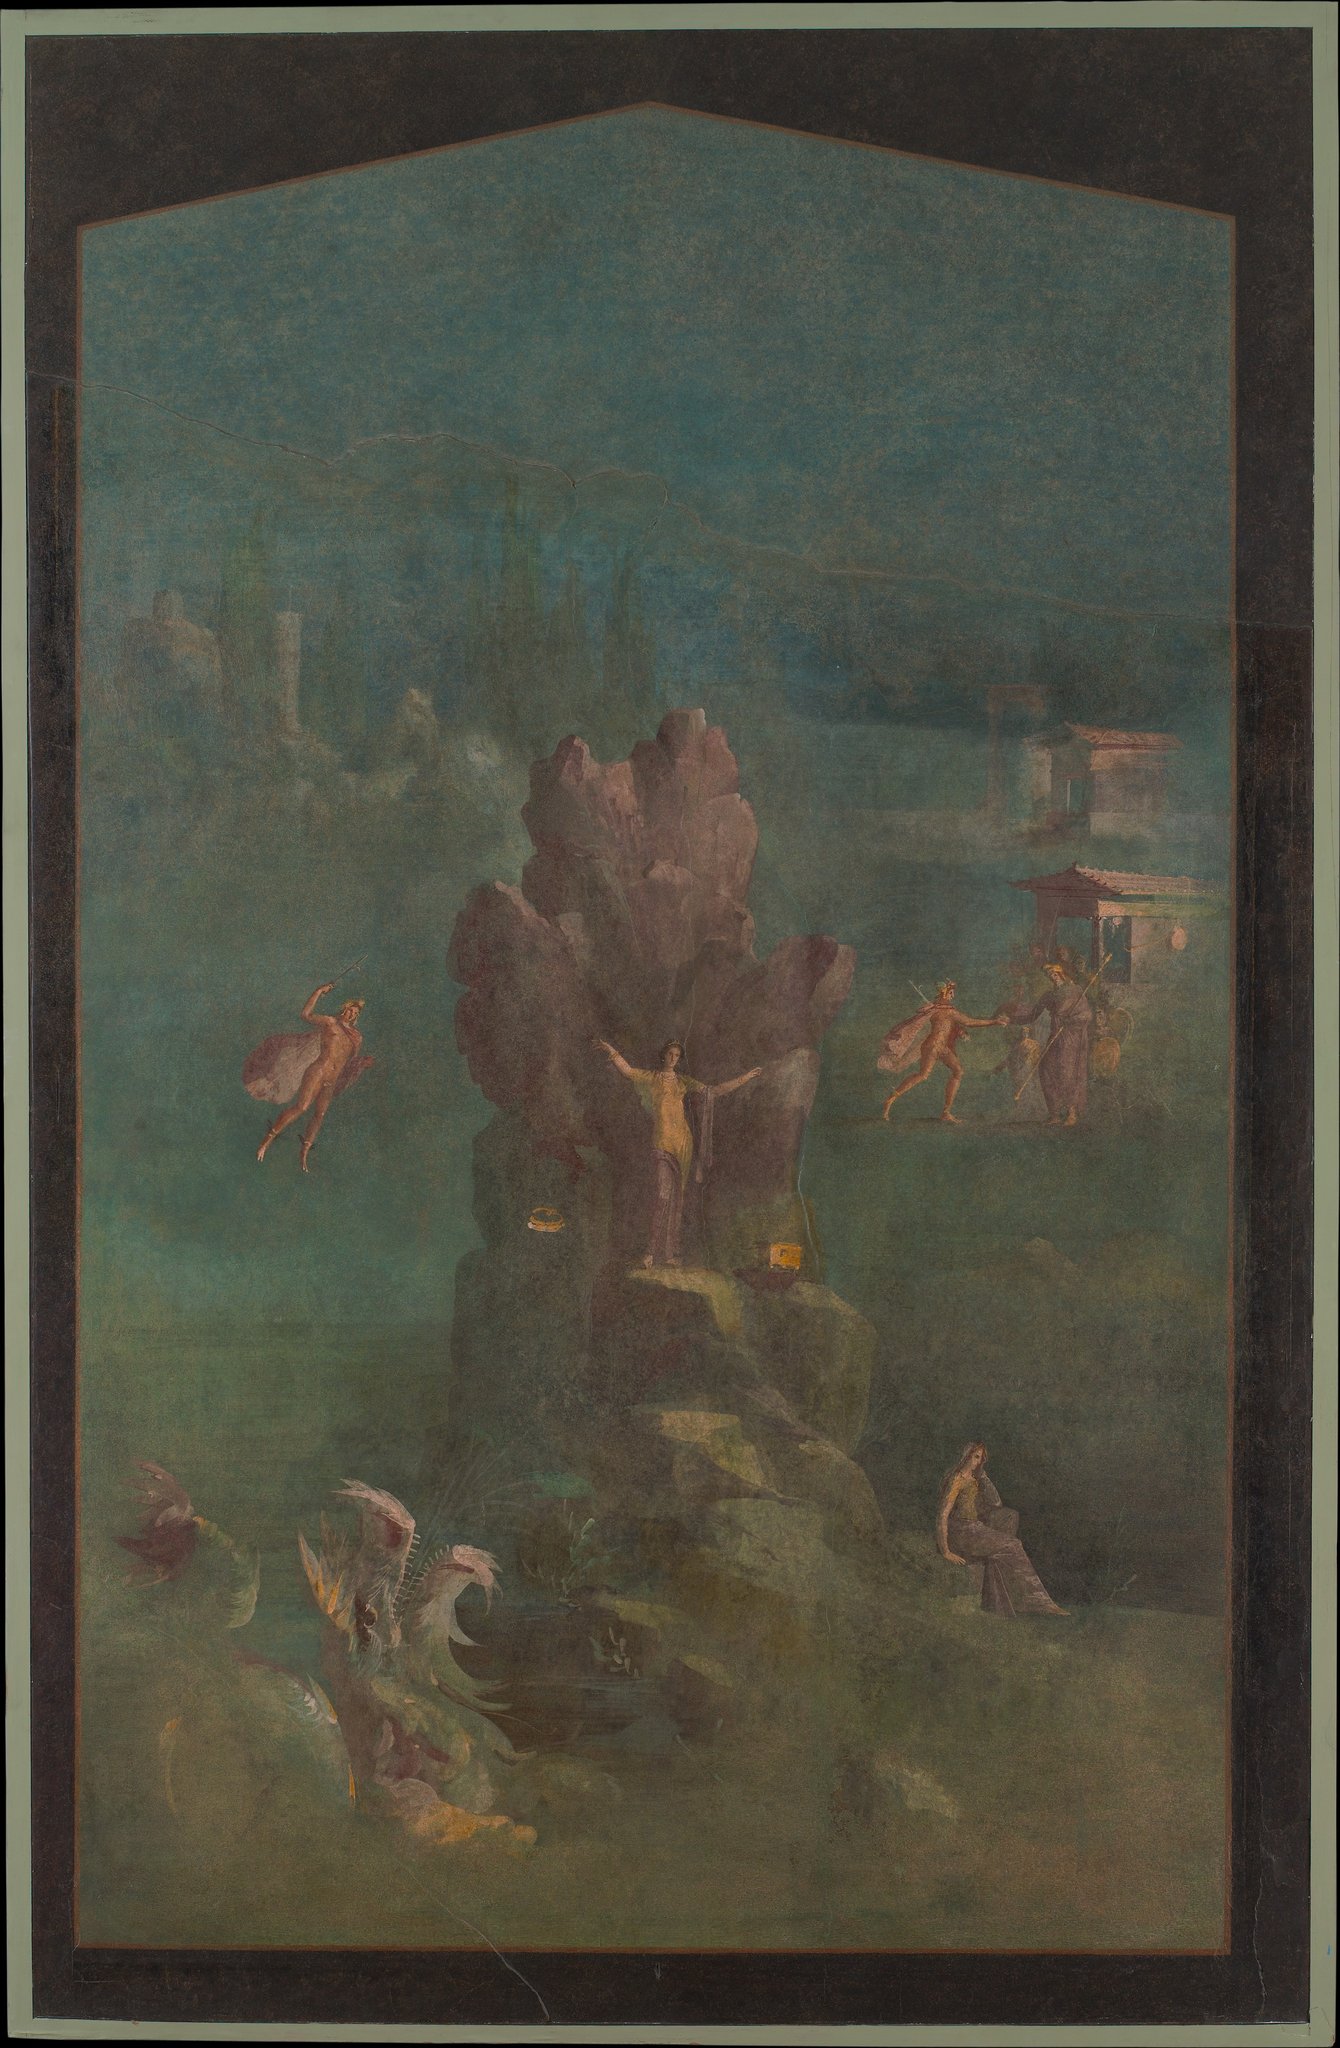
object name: wall painting perseus and andromeda in landscape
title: Wall painting: Perseus and Andromeda in landscape, from the imperial villa at Boscotrecase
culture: roman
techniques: fresco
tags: men,women,andromeda,perseus,landscapes